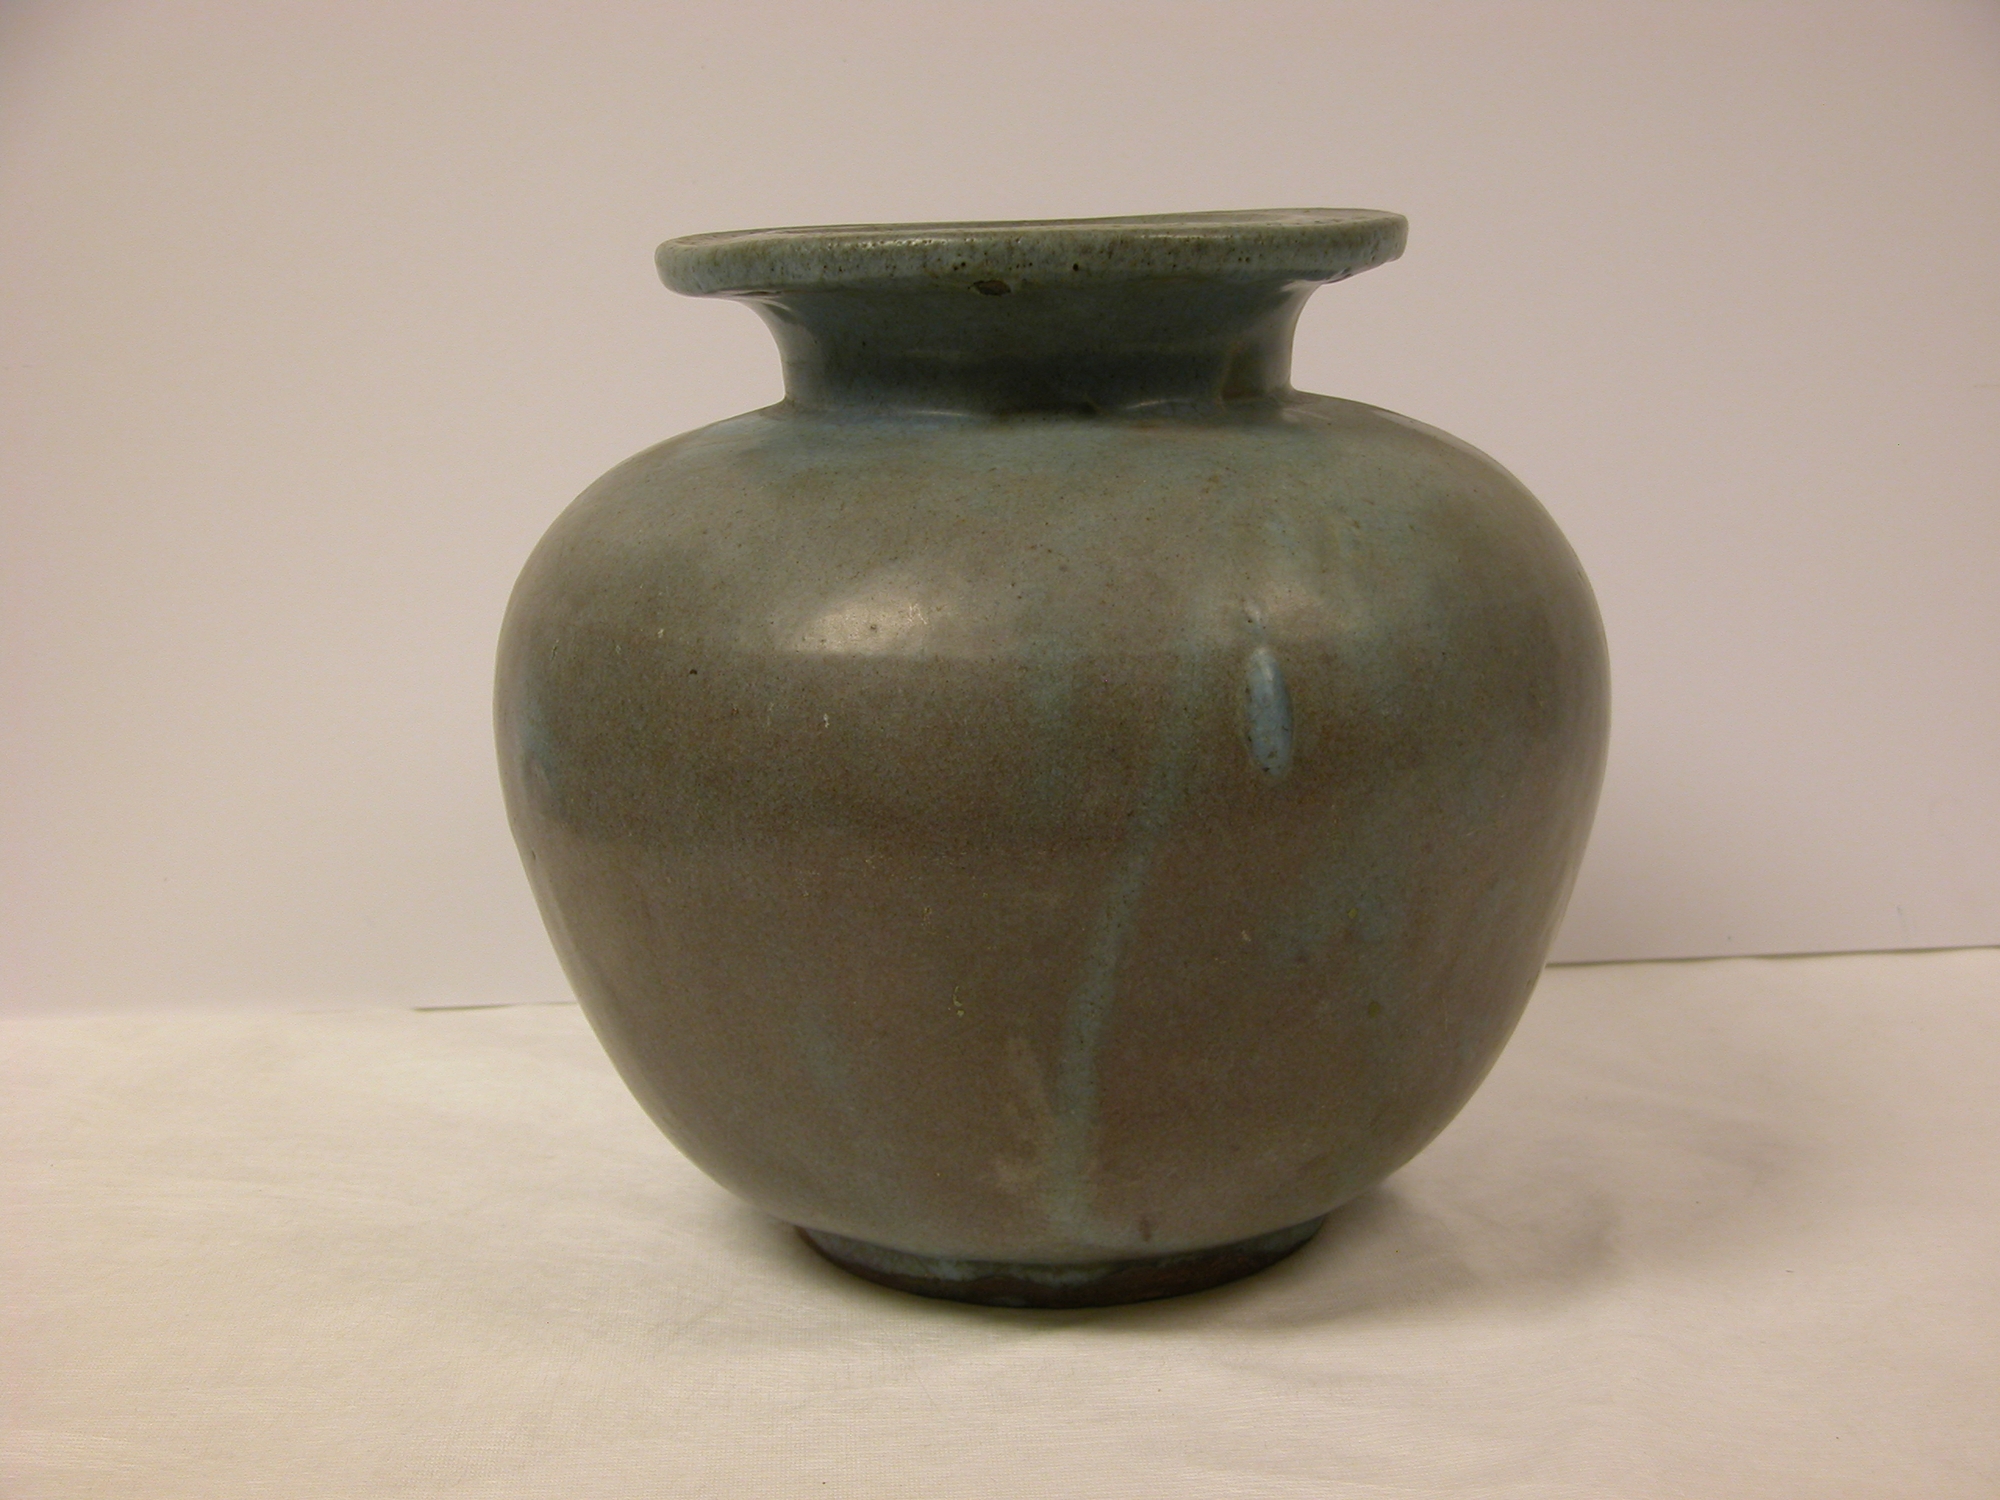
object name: vase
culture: chinese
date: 1279-1368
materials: pottery